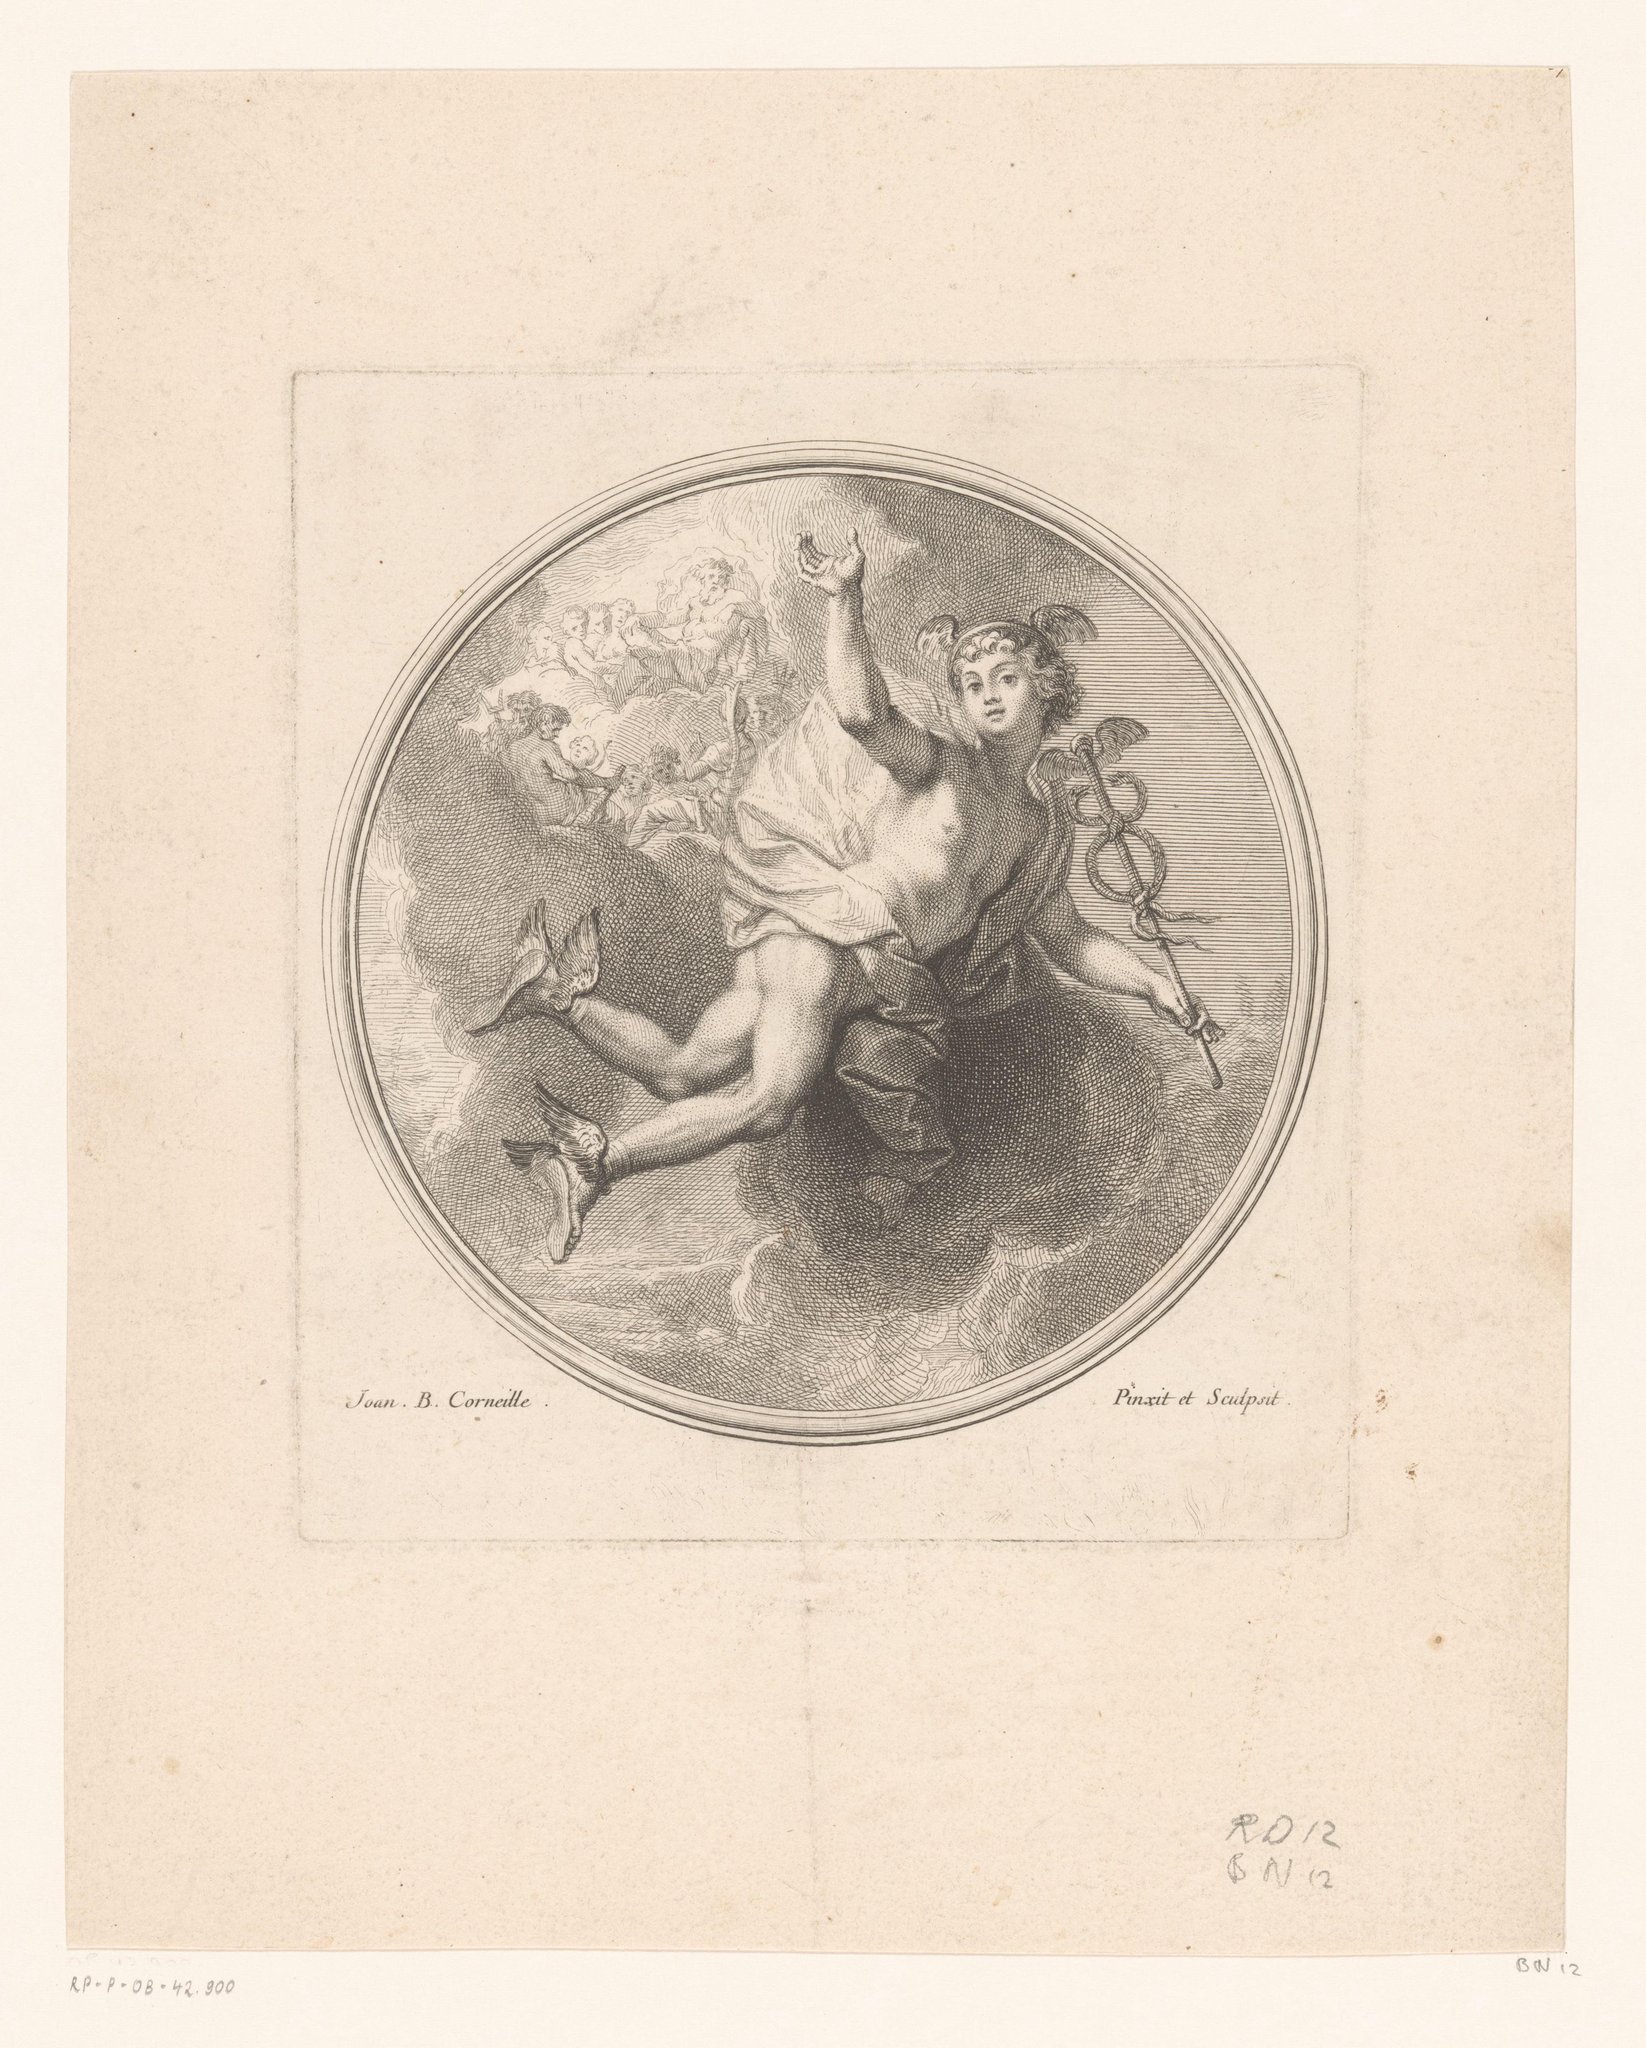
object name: print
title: Mercurius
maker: jean-baptiste corneille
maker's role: print maker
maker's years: 1649-1695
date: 1659-1695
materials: paper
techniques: engraving, etching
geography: france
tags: (story of) mercury (hermes)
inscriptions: collector's mark: Lugt 240